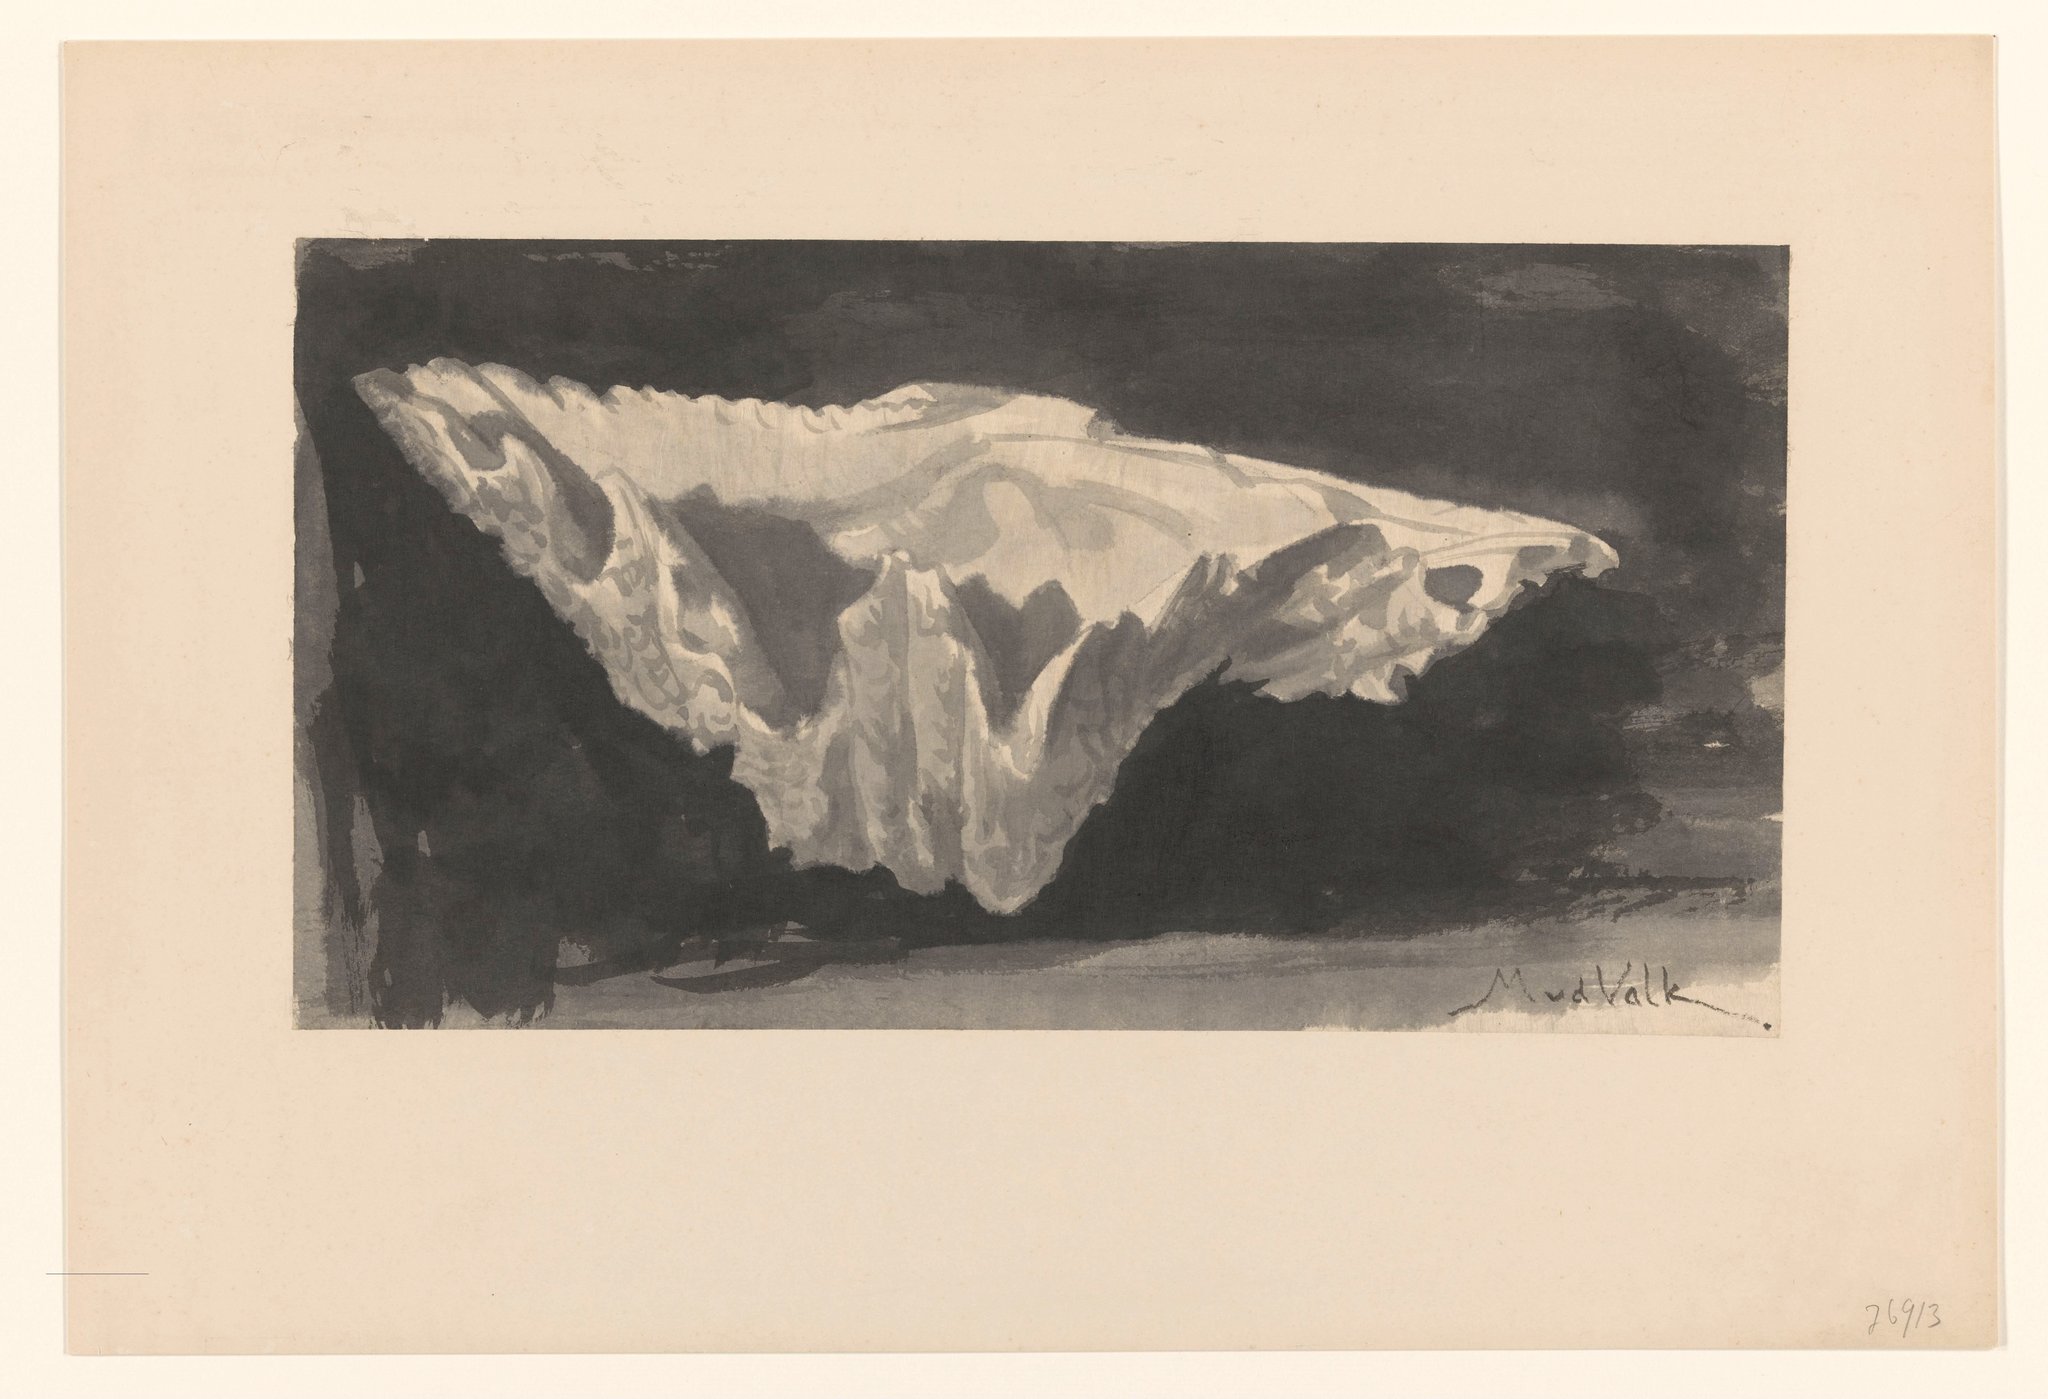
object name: drawing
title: Schelp tegen zwart fond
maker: maurits van der valk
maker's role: draughtsman, print maker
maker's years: 1857-1935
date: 1867-1935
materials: paper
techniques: brush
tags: molluscs (+ shell, snail-shell etc.)